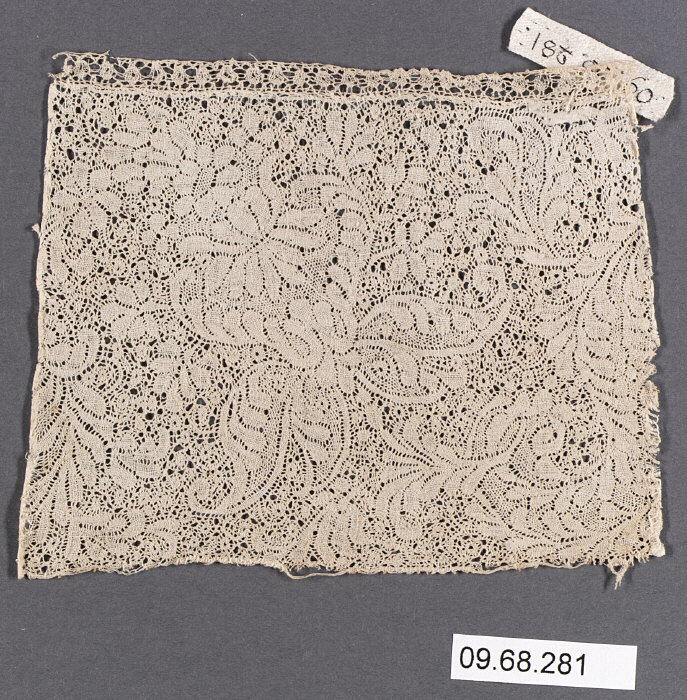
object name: fragment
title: Fragments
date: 1701-1800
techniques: lace